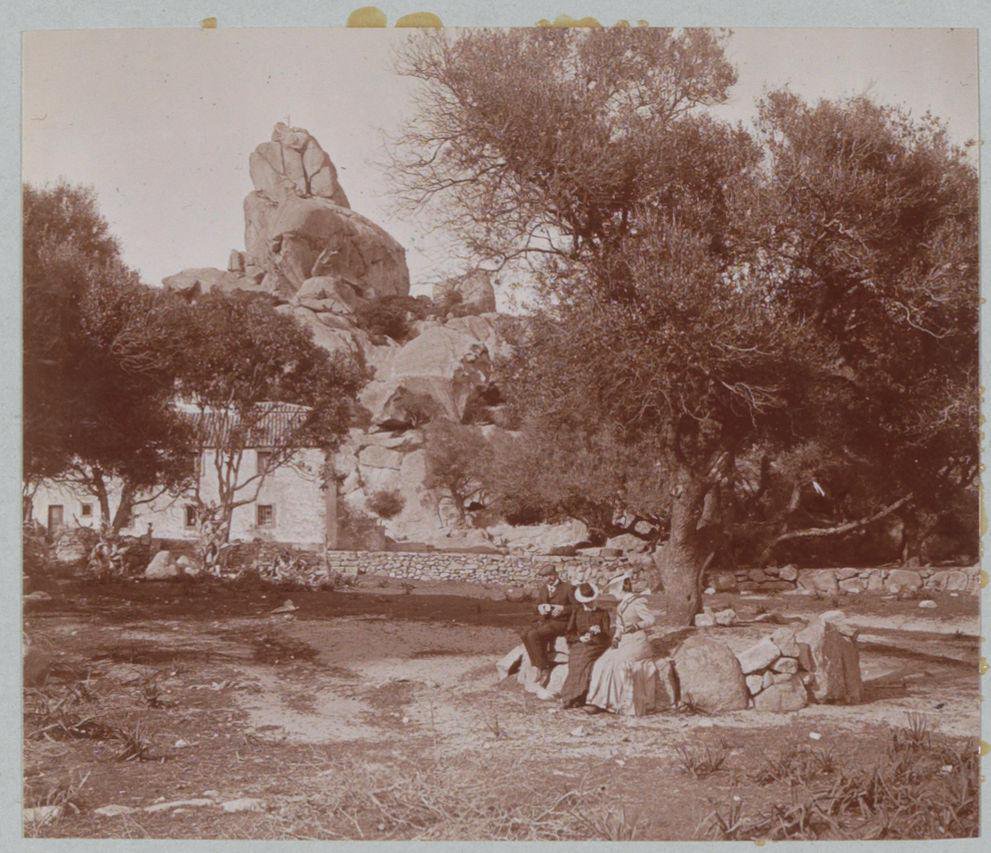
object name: photograph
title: Twee vrouwen en een man picknickend op rotsen, vermoedelijk op Corsica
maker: Anonymous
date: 1905-1910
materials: paper, photographic support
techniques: gelatin silver print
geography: corsica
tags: travelling; tourism, eating and drinking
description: Onderdeel van Fotoalbum van een Franse amateurfotograaf met bezienswaardigheden in Frankrijk, Zwitserland en Italië.